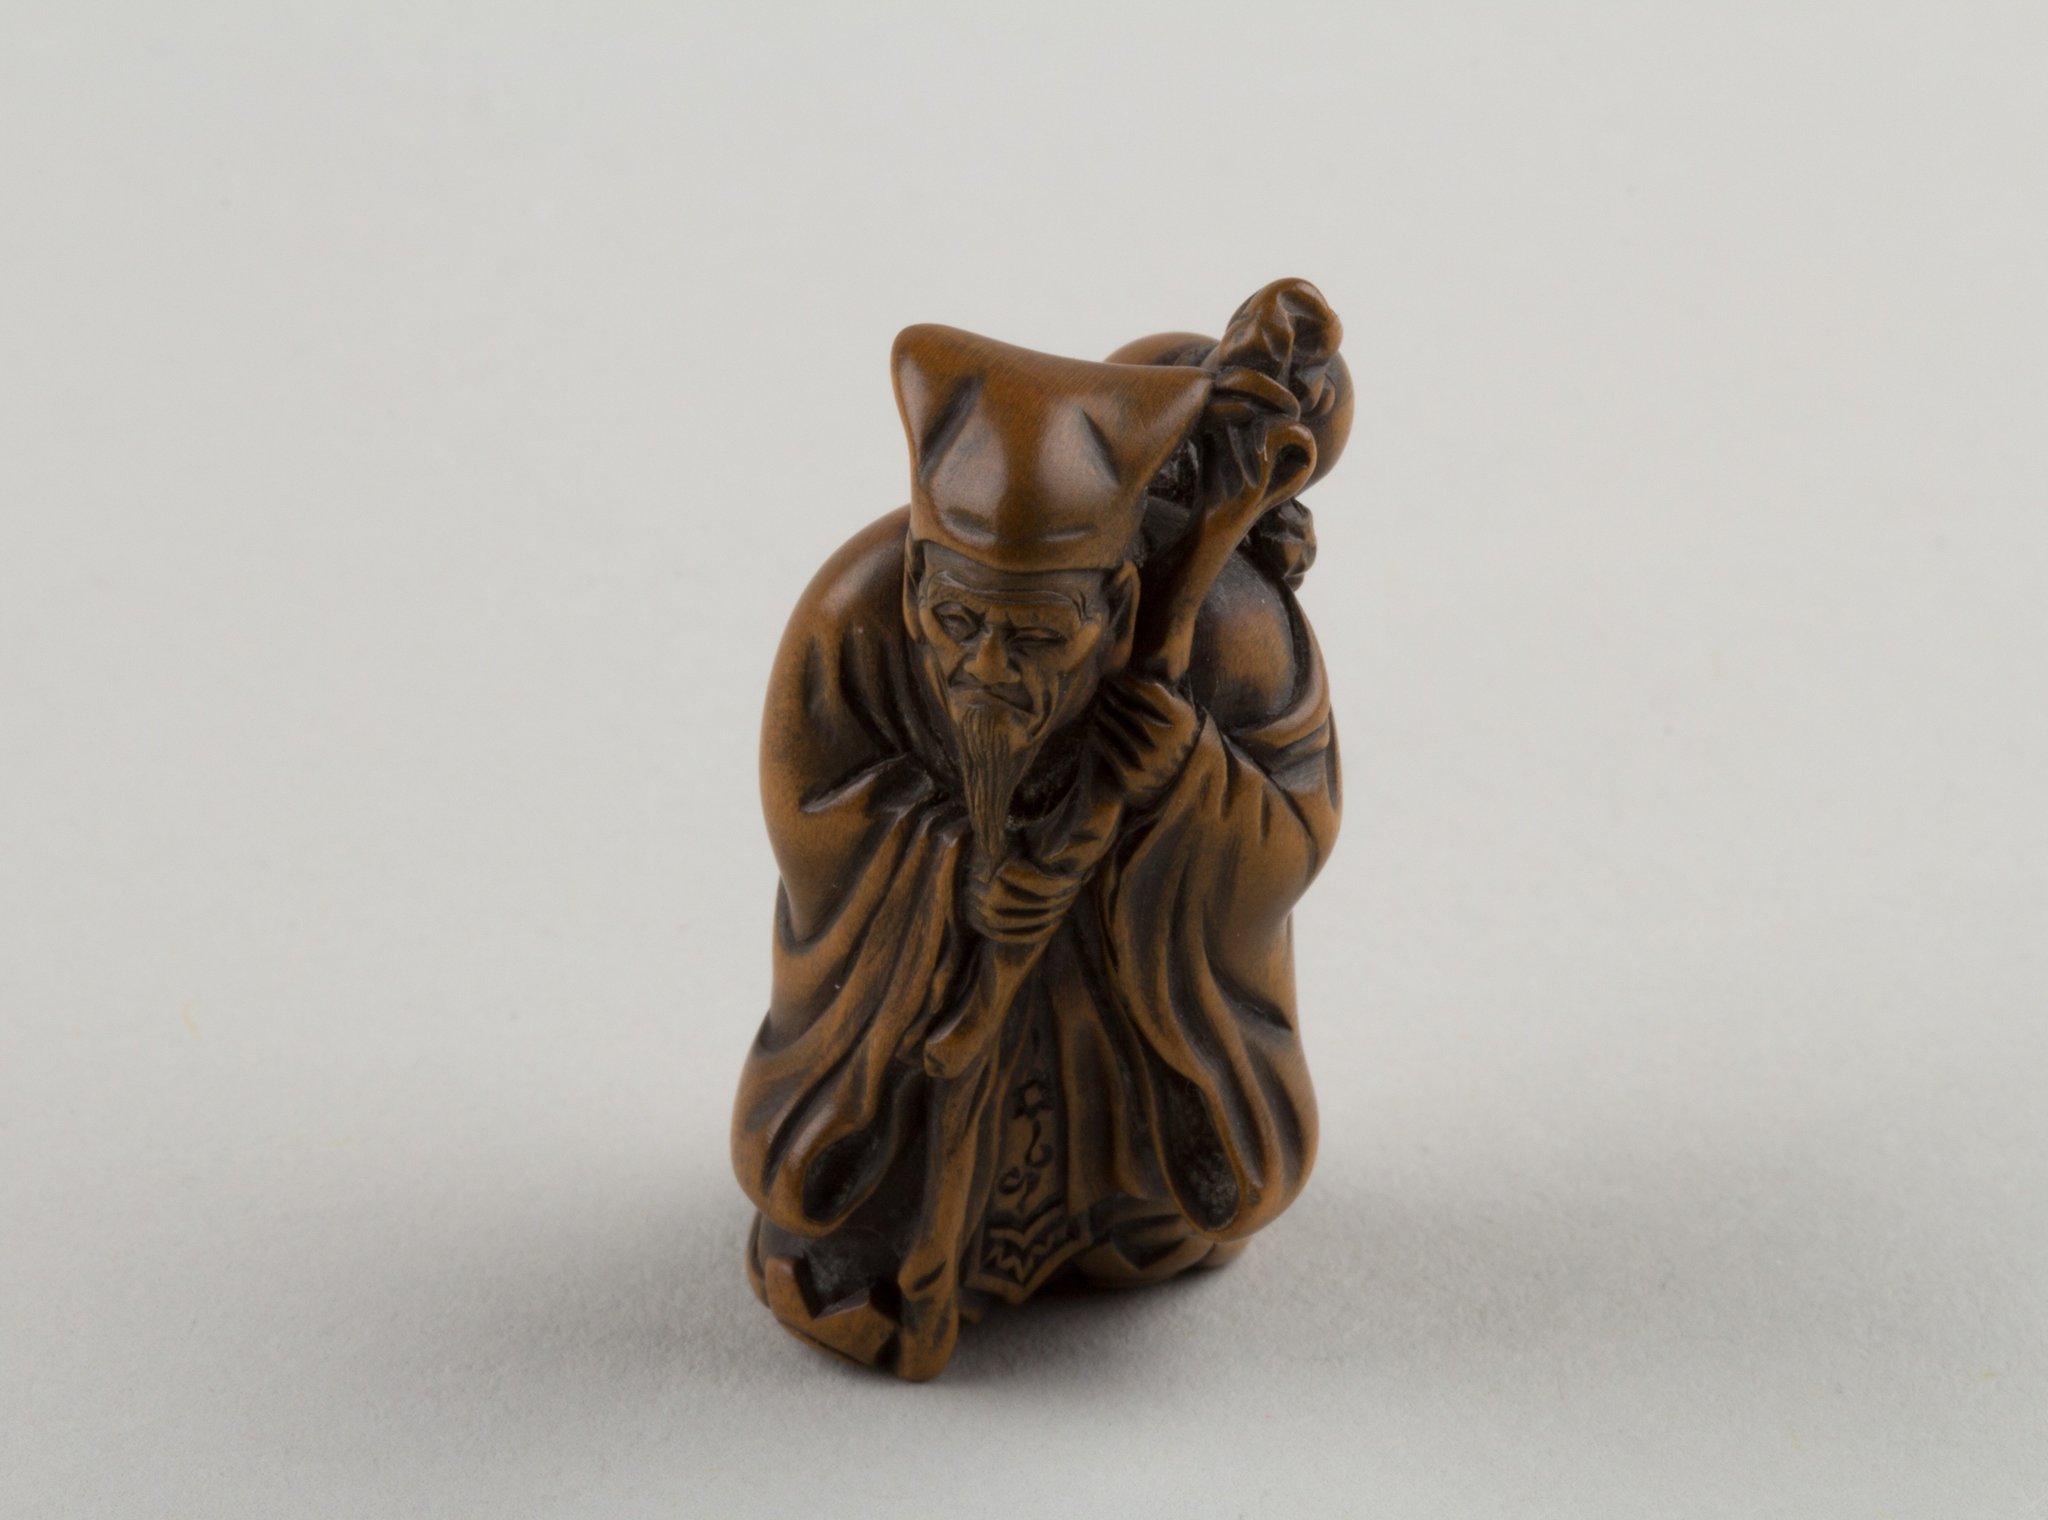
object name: netsuke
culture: japanese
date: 1801-1900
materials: wood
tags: human figures